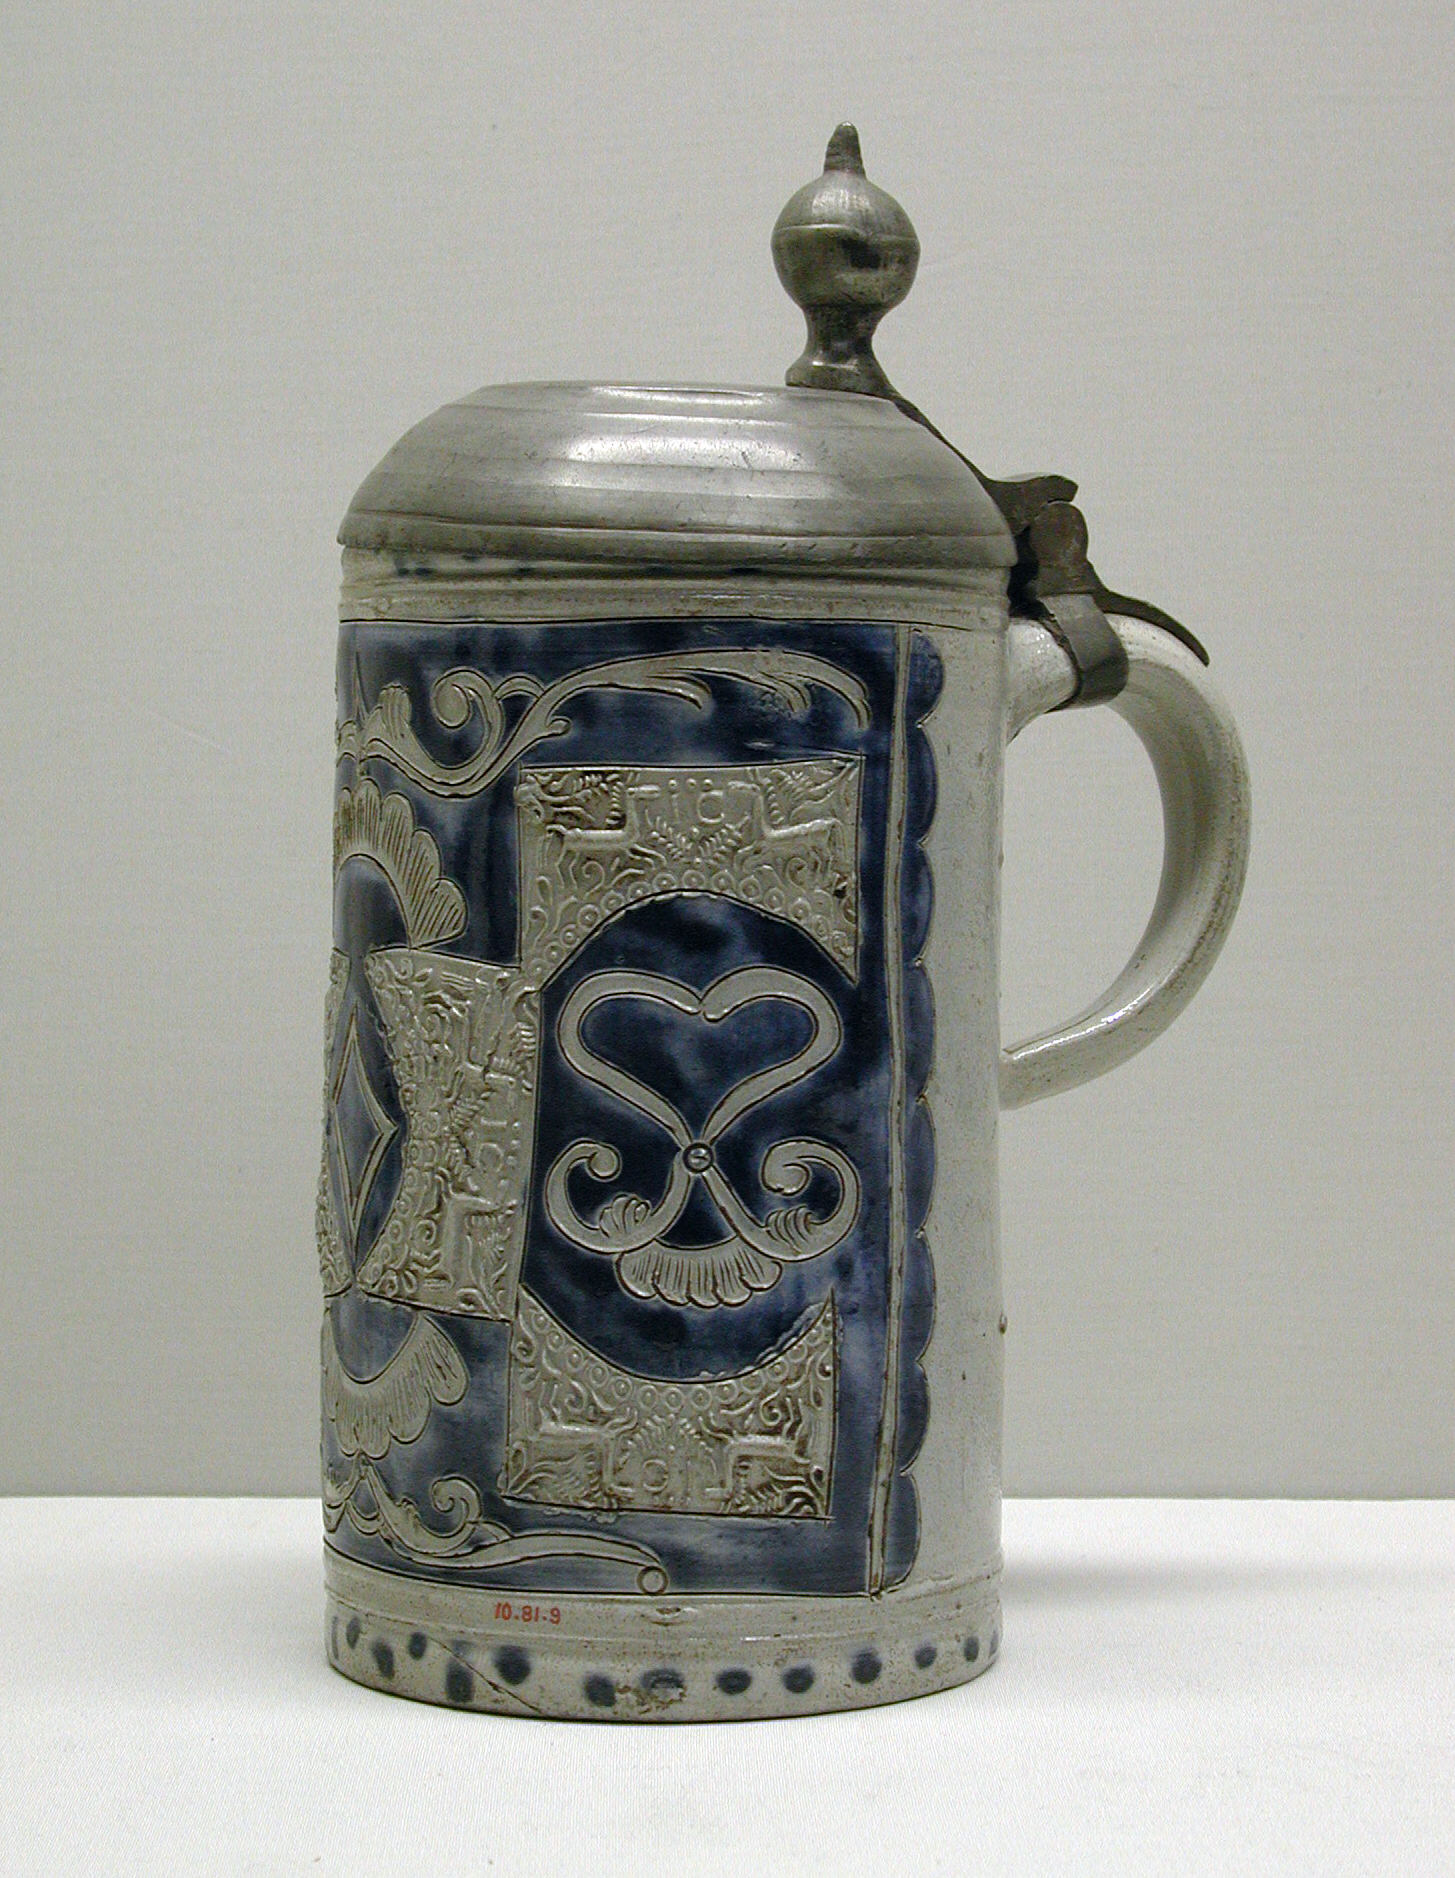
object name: tankard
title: Tankard (Stein)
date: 1701-1800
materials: pewter, stoneware